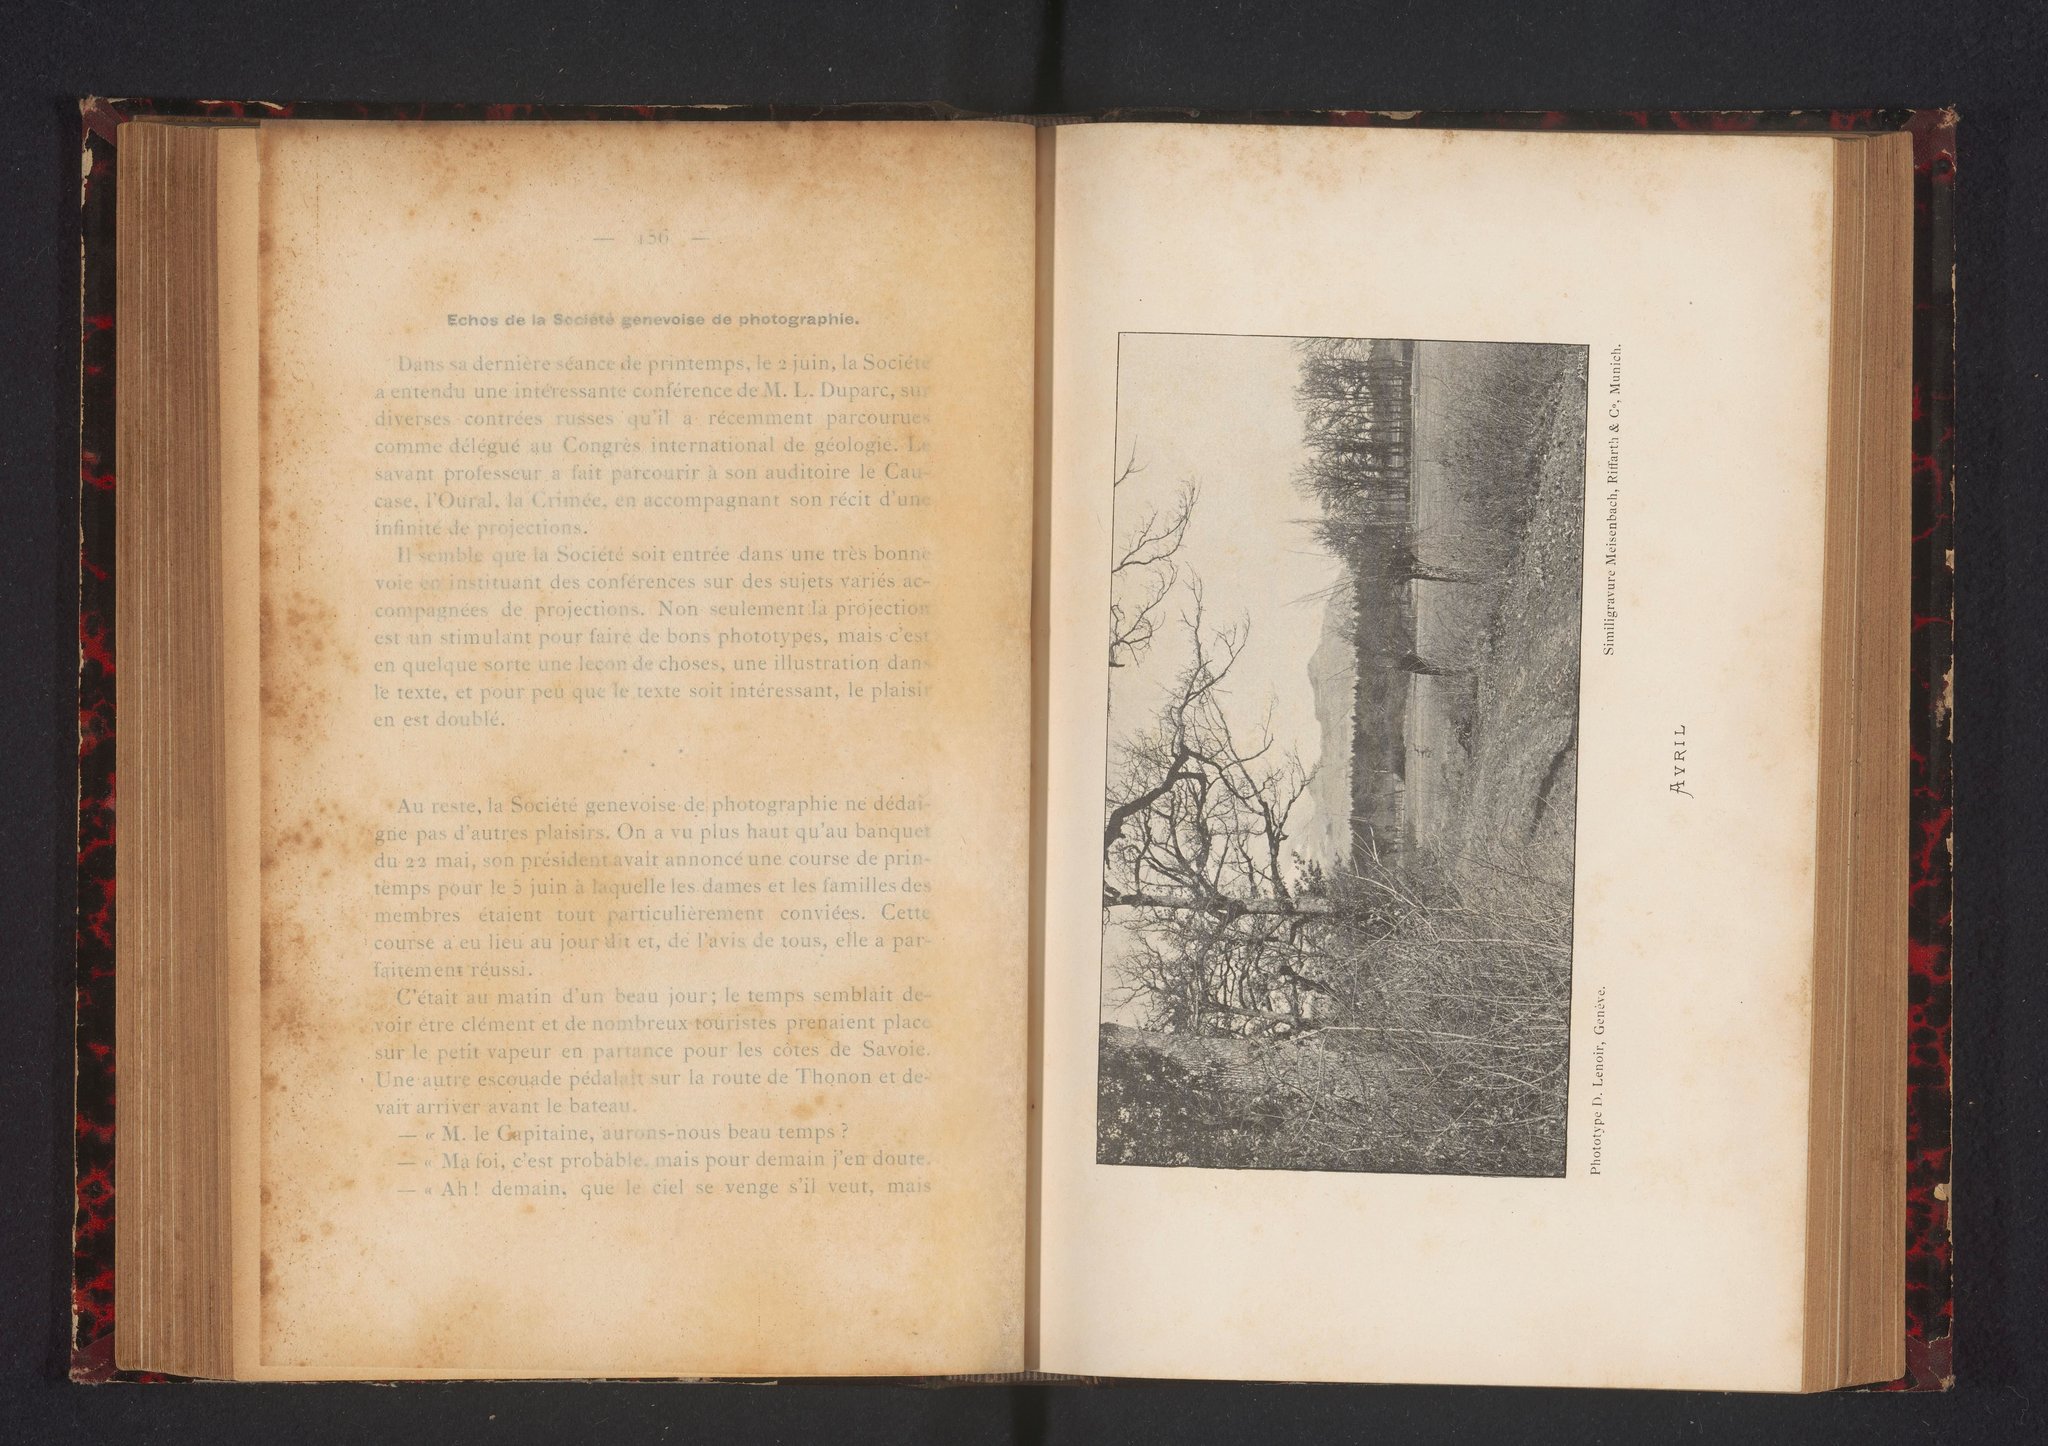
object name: page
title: Landschap, vermoedelijk in Zwitserland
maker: d. lenoir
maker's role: fotograaf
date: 1893-1898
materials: paper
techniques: autotype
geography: munich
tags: landscapes